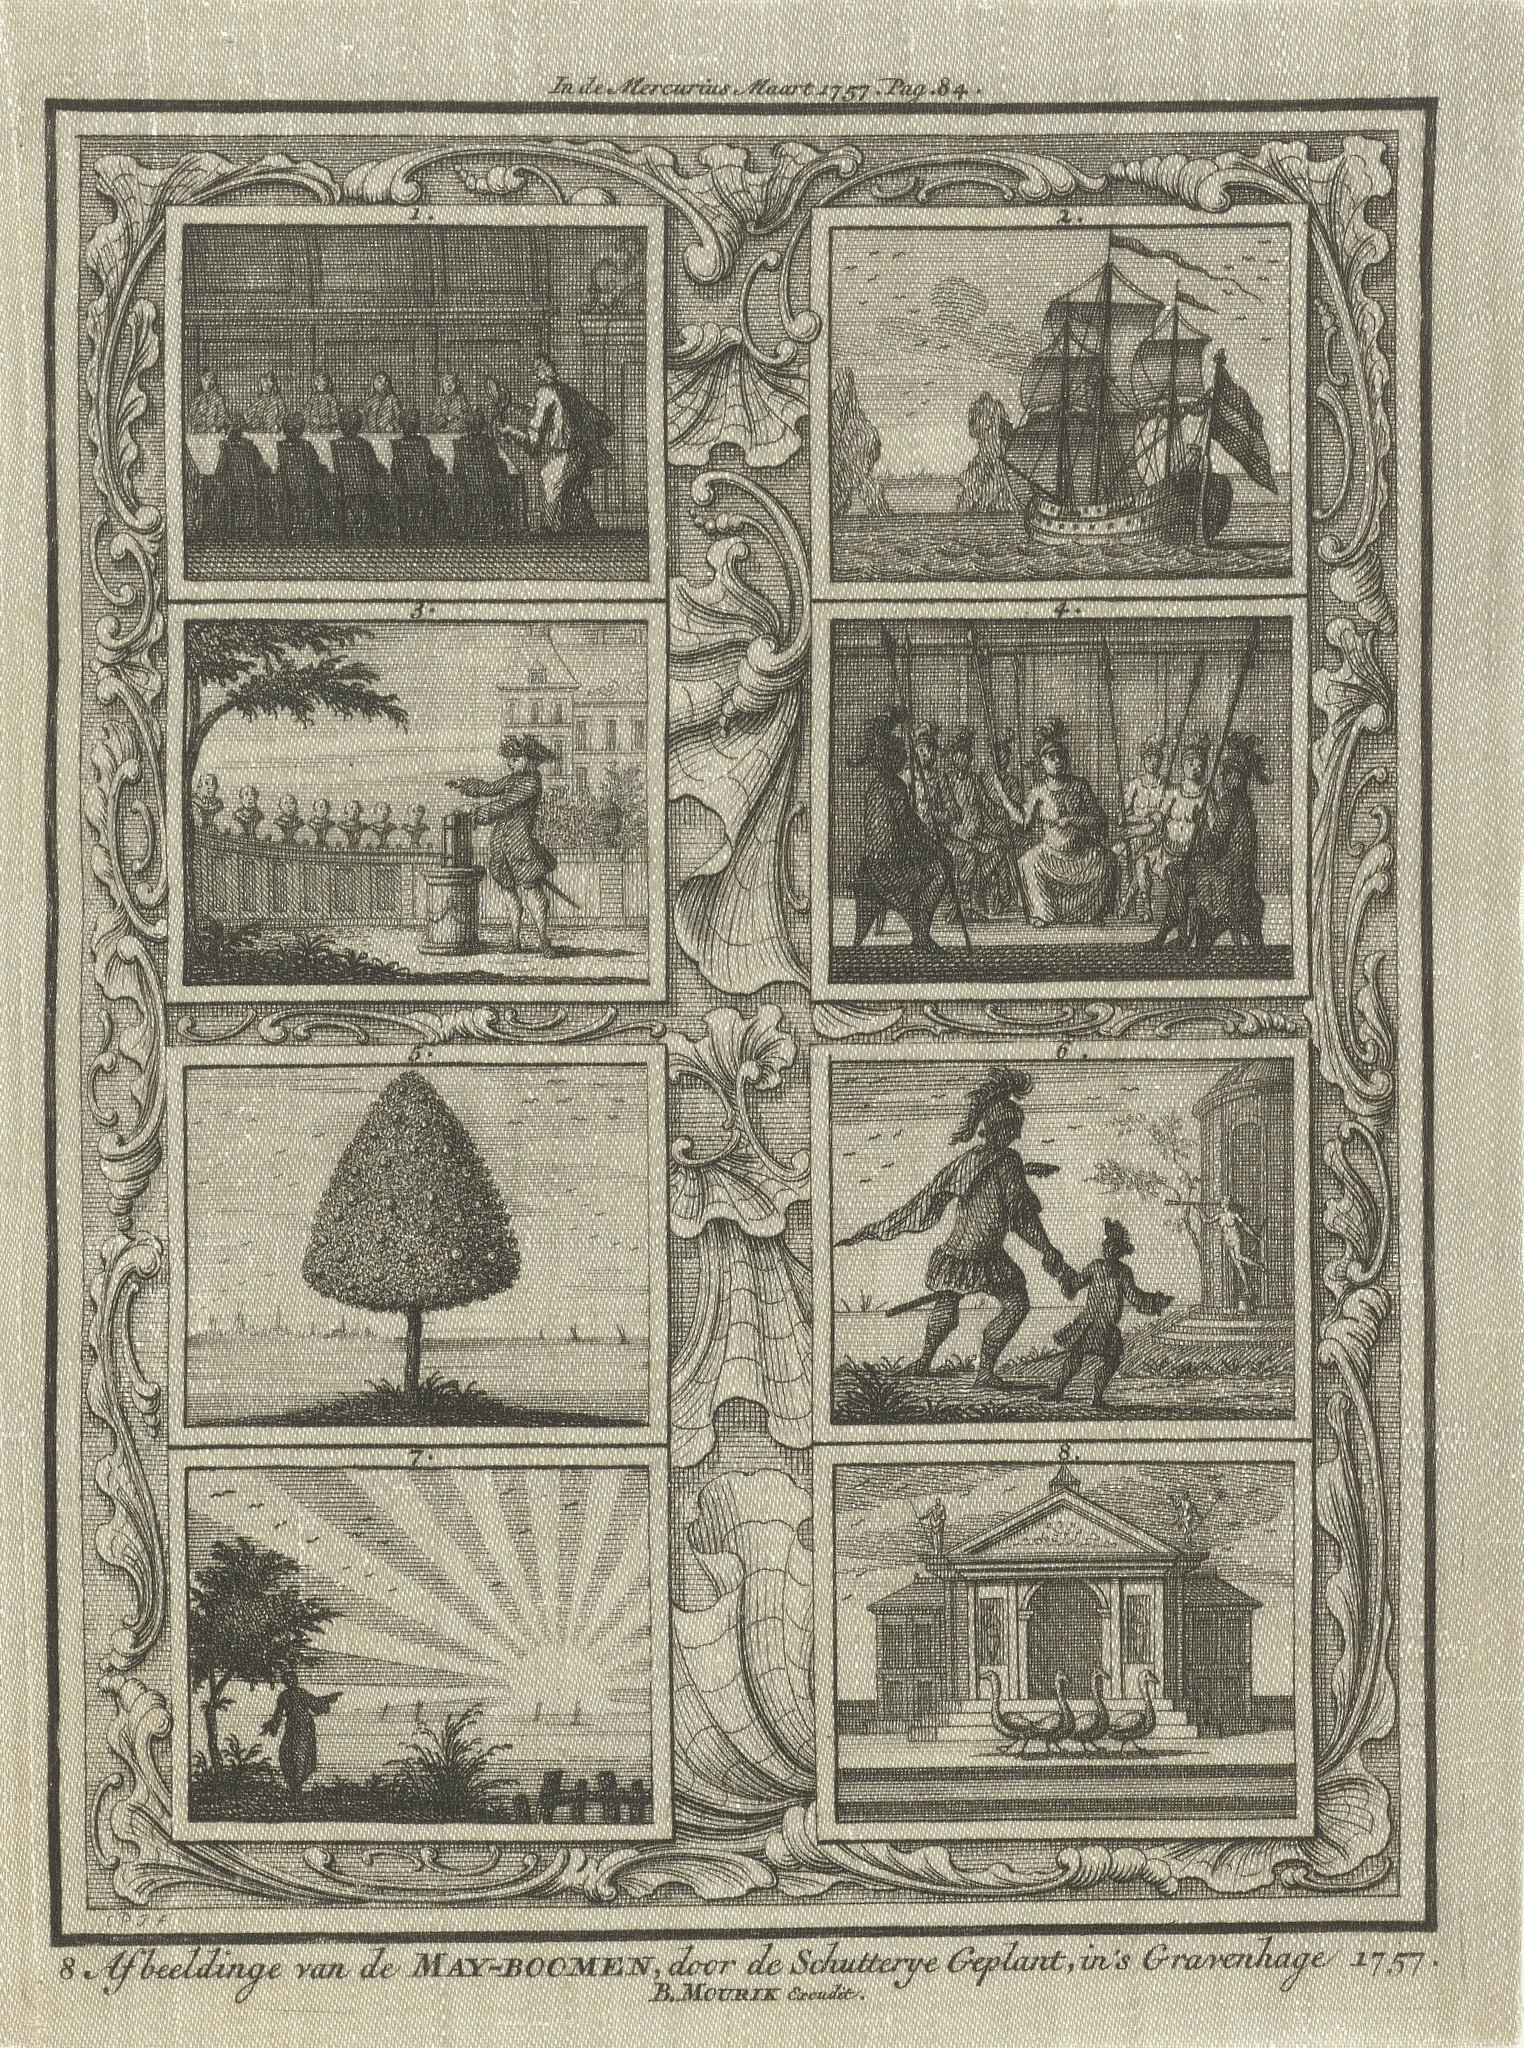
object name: print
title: Meiboom geplant door de Haagse Schutterij, 1757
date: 1757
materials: textile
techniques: engraving, etching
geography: northern netherlands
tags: maypole, the hague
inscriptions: collector's mark: Lugt 2228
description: De acht allegorische voorstellingen of emblemen van de meiboom geplant door de Schutterij van Den Haag in het jaar 1757.